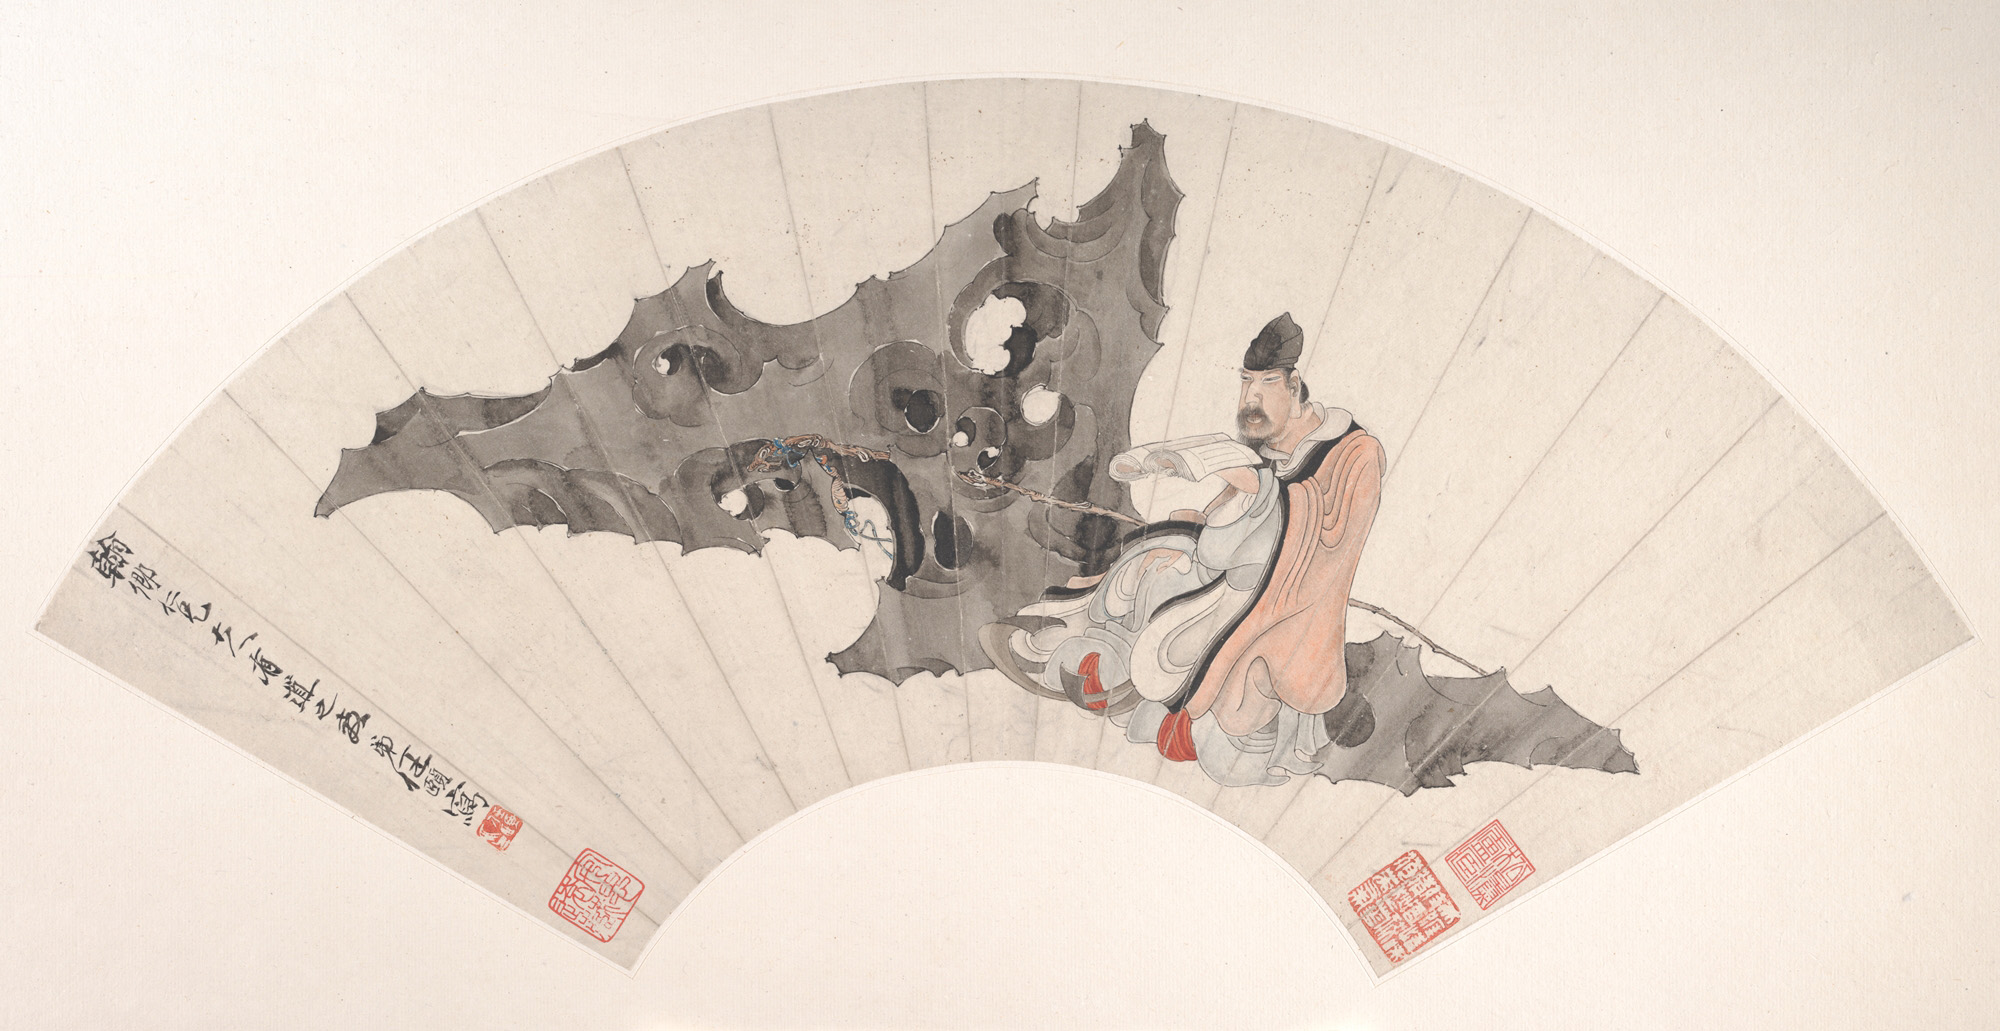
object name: folding fan mounted a an album leaf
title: Scholar on a rock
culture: chinese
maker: ren yi (ren bonian)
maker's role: artist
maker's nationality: chinese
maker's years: 1840-1896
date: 1880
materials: ink, paper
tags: men